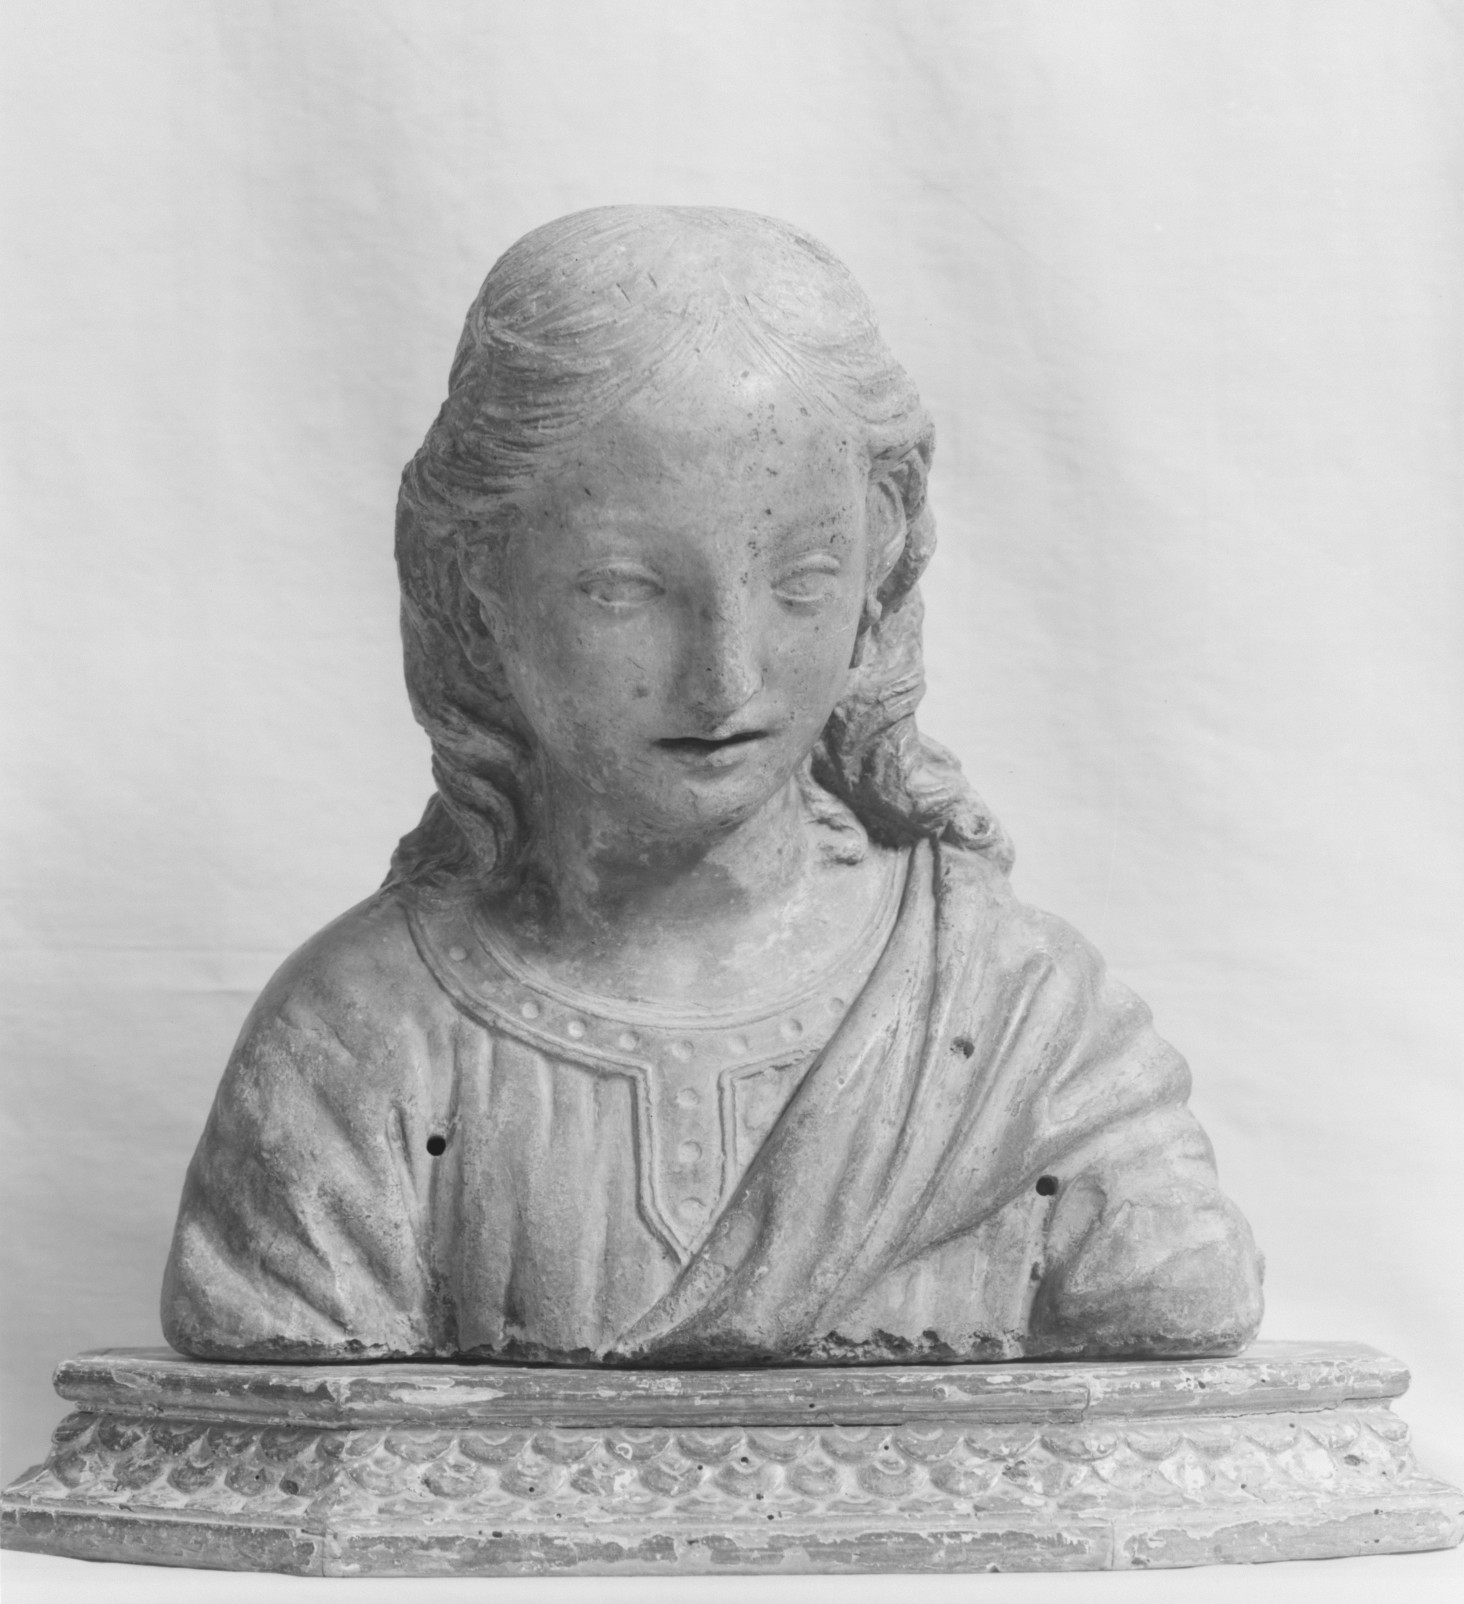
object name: bust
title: Renaissance-style bust of the boy Christ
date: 1801-1900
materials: gilt, plaster, wood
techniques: carving, polychromy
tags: christ